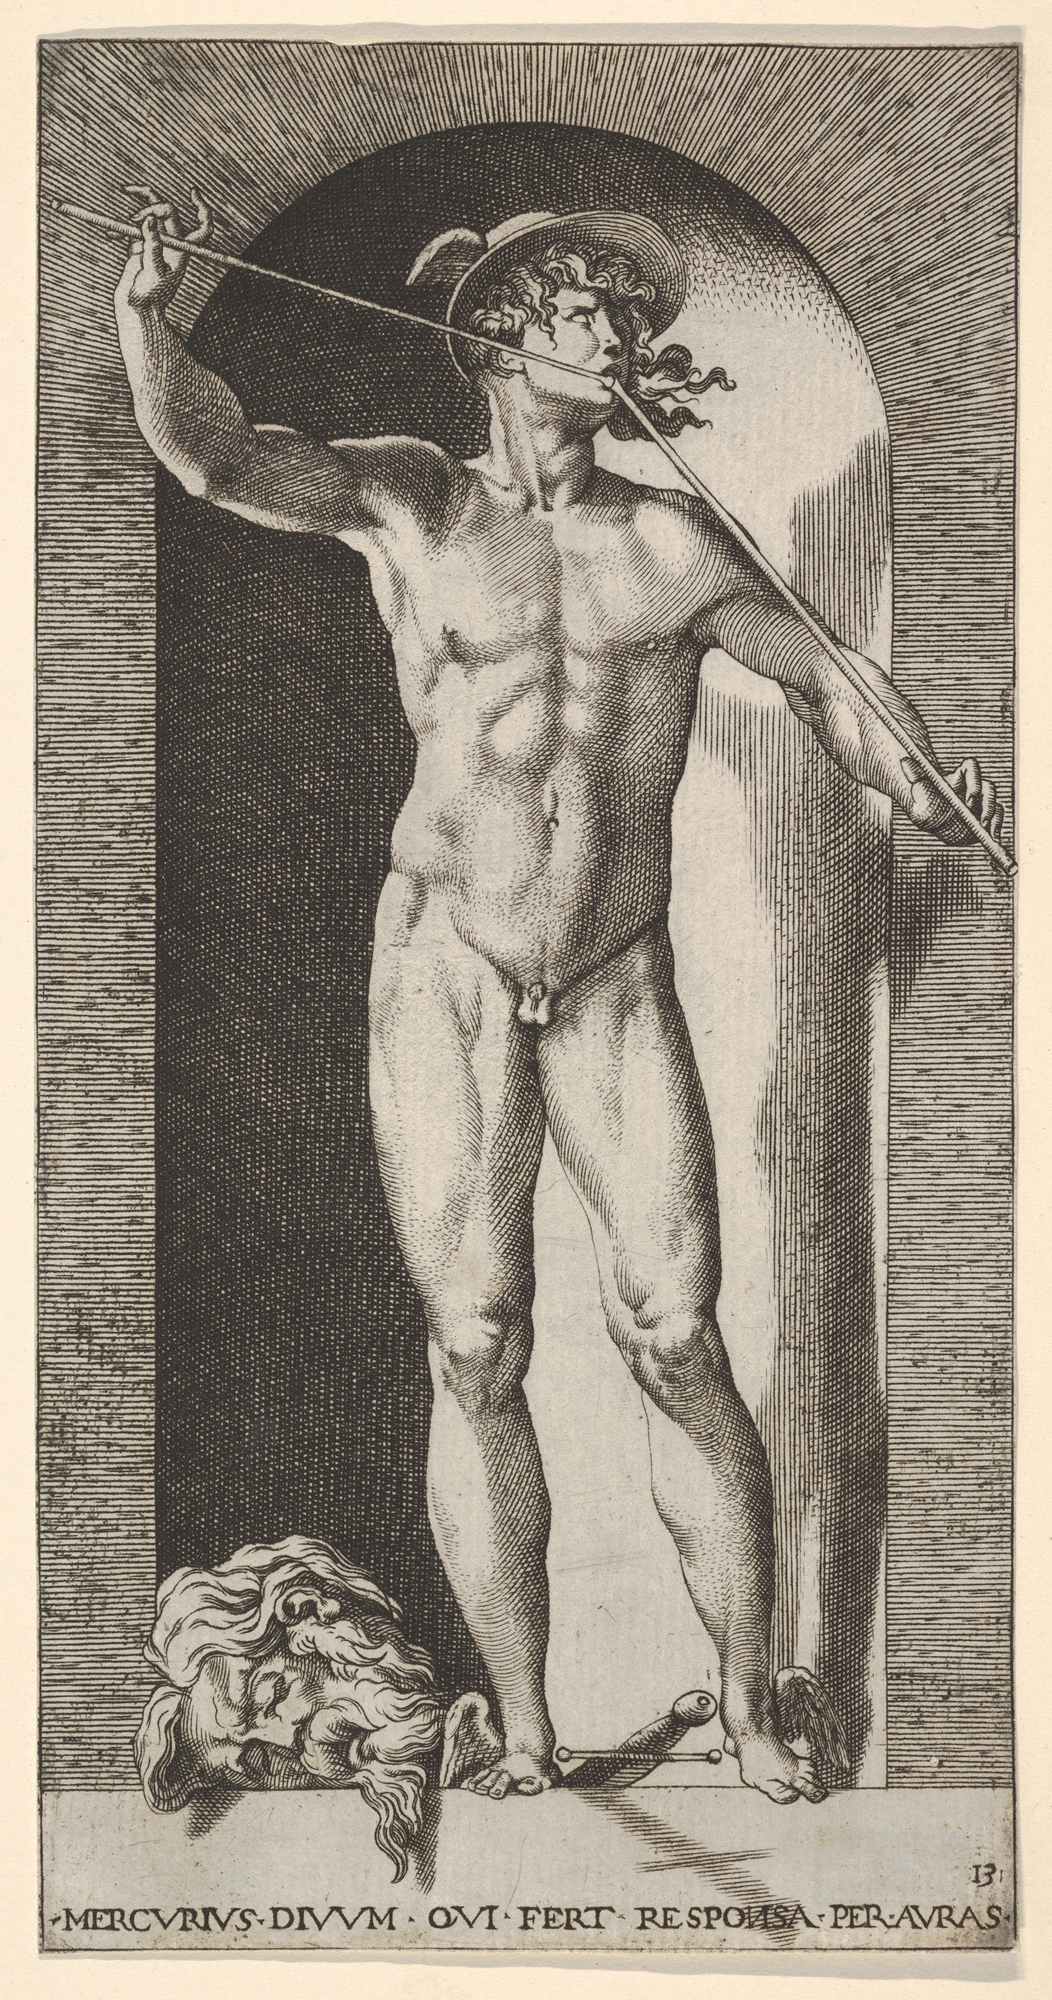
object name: print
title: Plate 14: Mercury standing in a niche playing his pipes, with the severed head of an old man and a sword at his feet, from "Mythological Gods and Goddesses"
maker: giovanni jacopo caraglio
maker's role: artist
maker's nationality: italian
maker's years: 1500-1565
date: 1526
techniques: engraving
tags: musical instruments,mercury